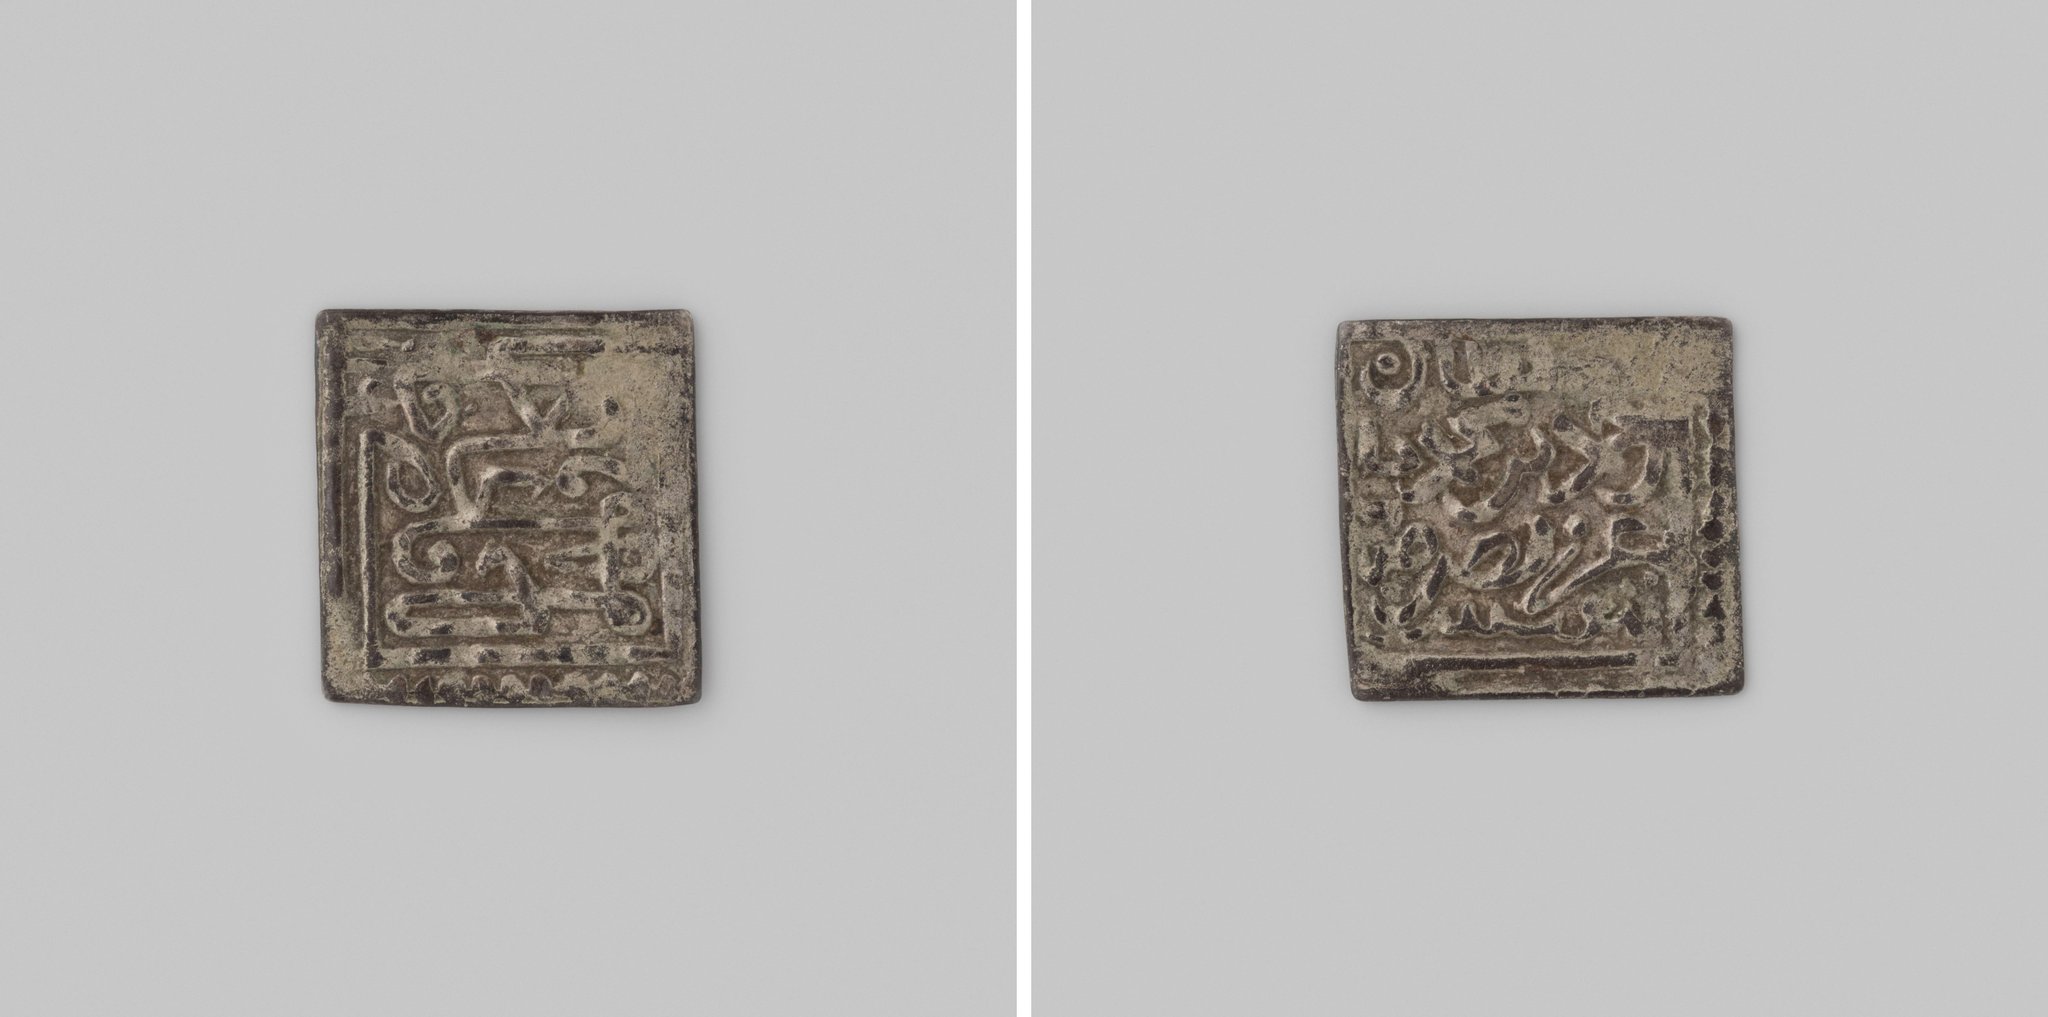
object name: coin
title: Para uit Tunesië van Sultan Ahmed VI Mohammed Khan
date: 1750-1850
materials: silver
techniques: striking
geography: tunisia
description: Zilveren rechthoekige munt. Voorzijde: vierregelig opschrift in Arabische letters. Keerzijde: vijfregelig opschrift in Arabische letters.